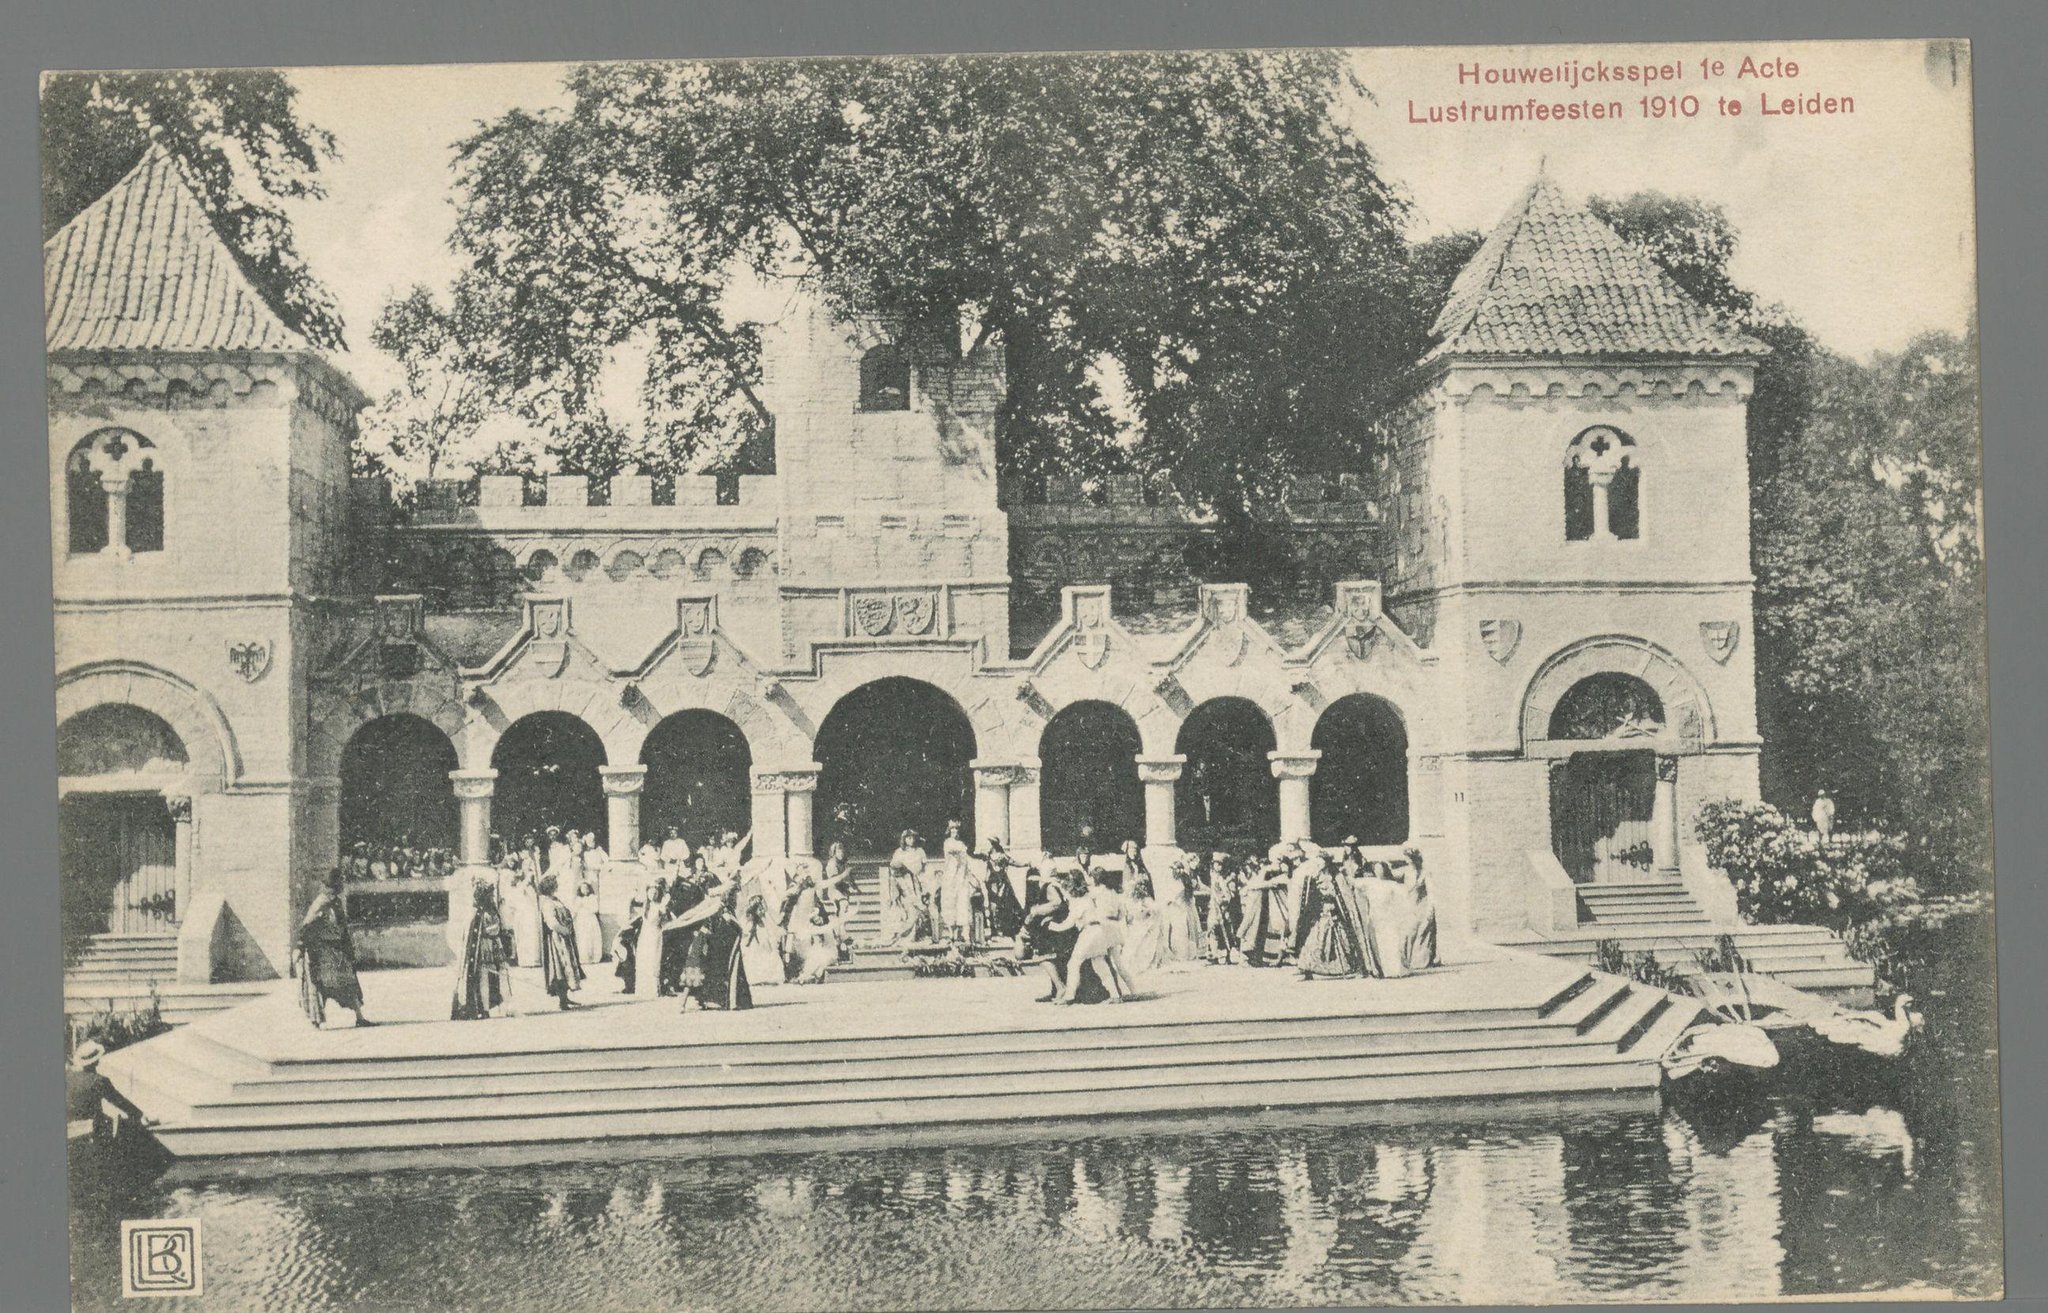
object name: ansichtkaart, prentbriefkaart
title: Houwelijcksspel 1e acte. Lustrumfeesten 1910 te Leiden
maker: Anonymous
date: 1910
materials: cardboard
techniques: photograph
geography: leiden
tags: theatre, theatrical performance, masquerade, masked ball, commemoration, jubilee, leiden